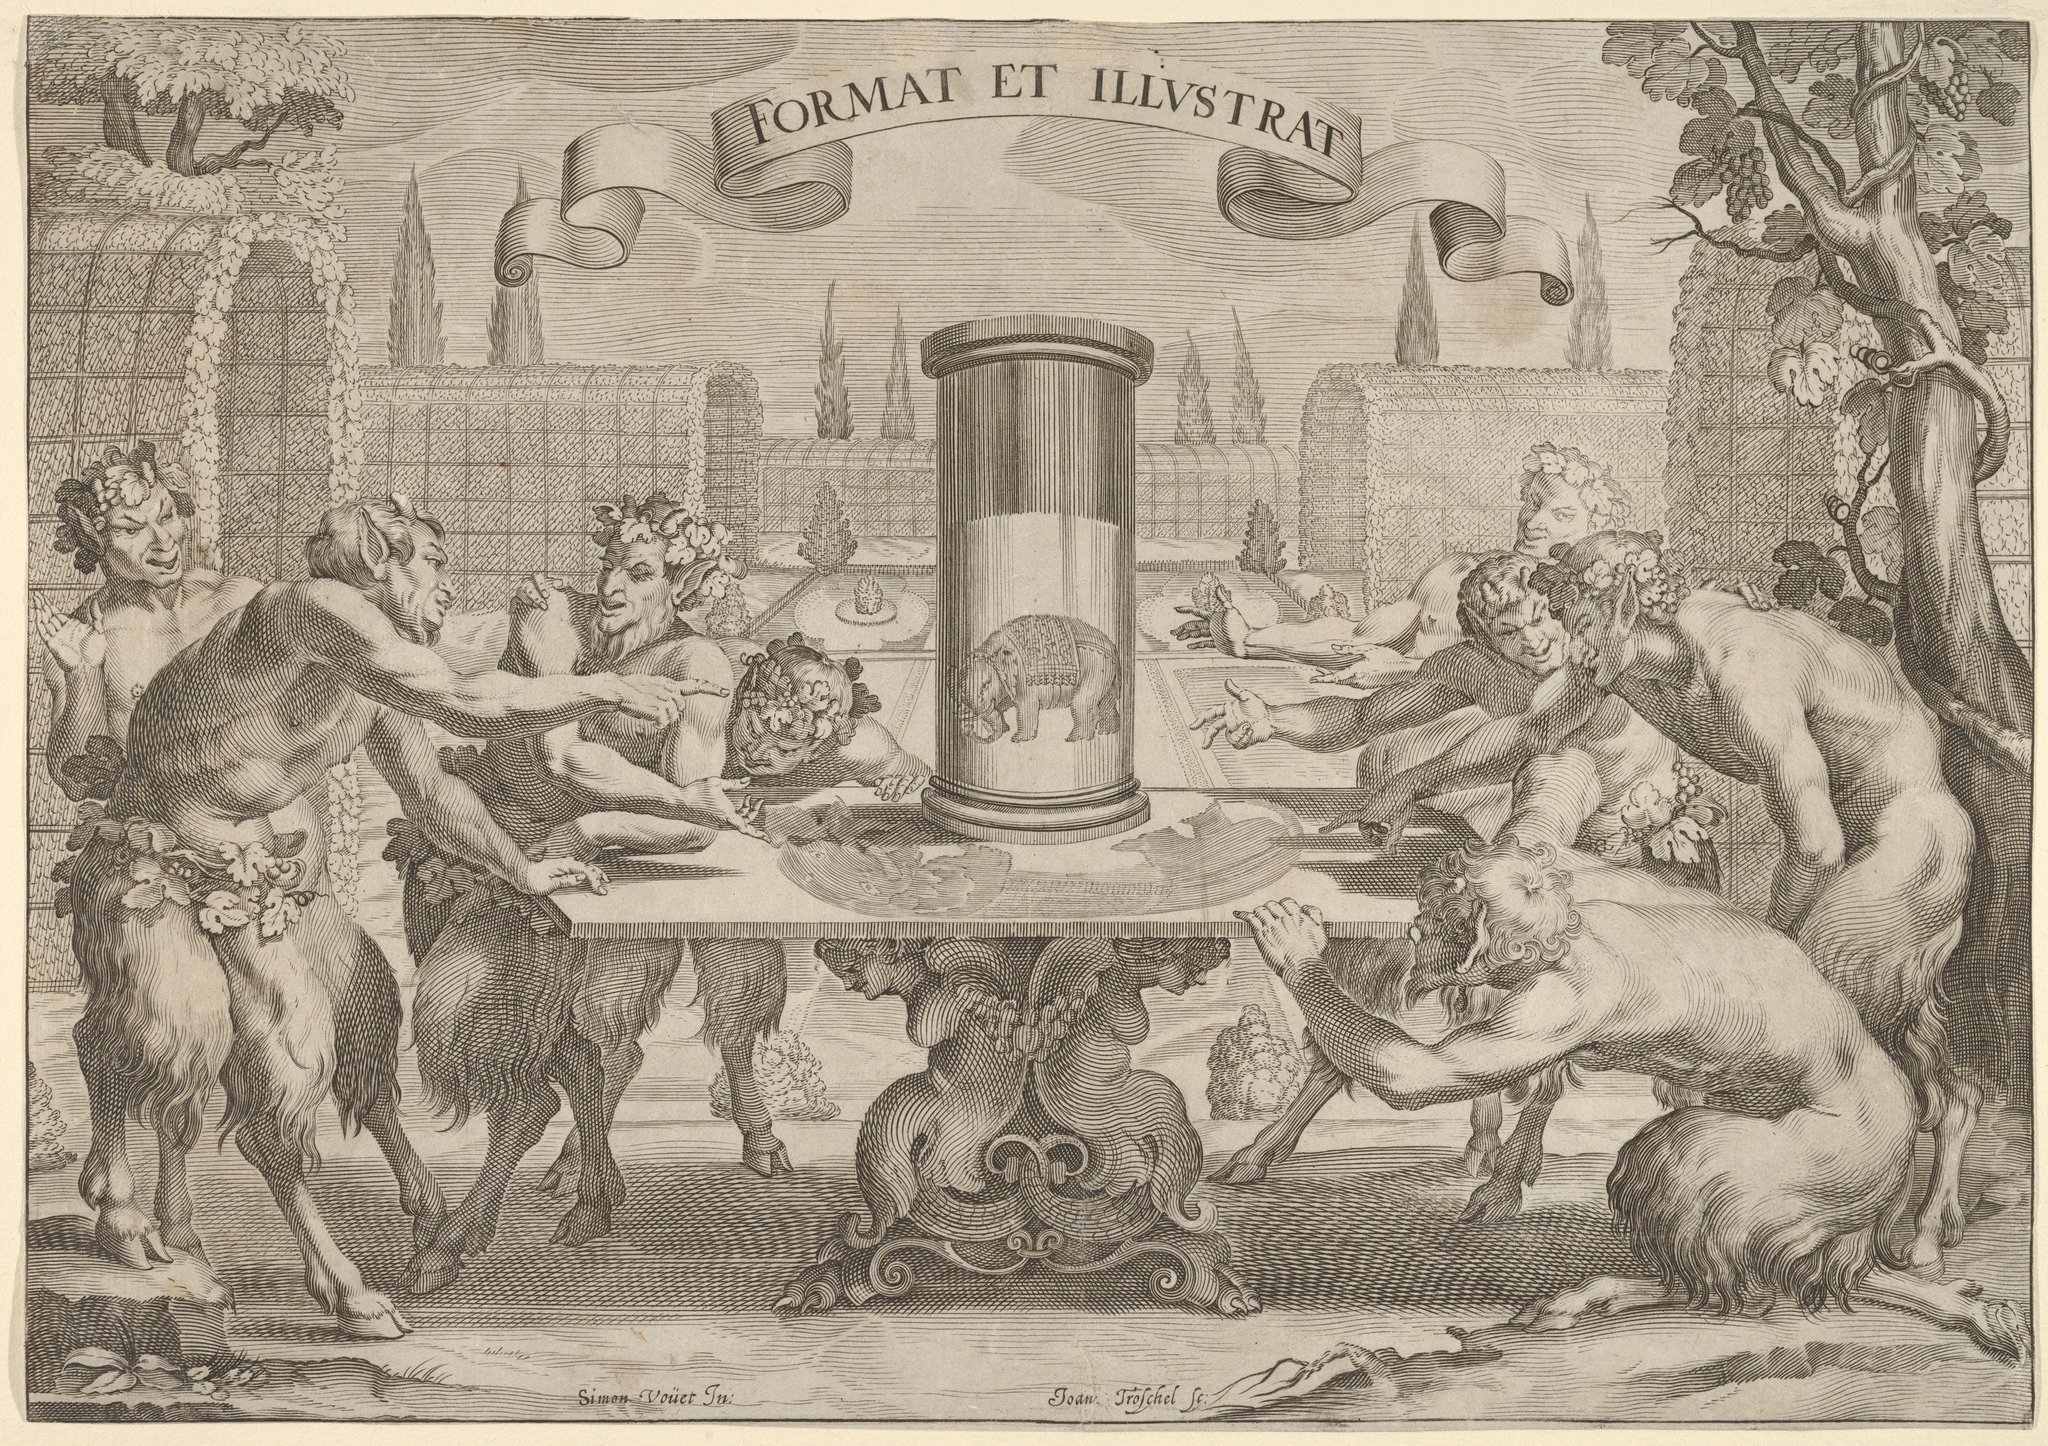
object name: print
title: Satyrs Admiring the Anamorphosis of an Elephant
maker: hans troschel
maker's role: artist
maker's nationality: german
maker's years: 1585-1628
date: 1601-1700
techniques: engraving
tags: satyrs,elephants